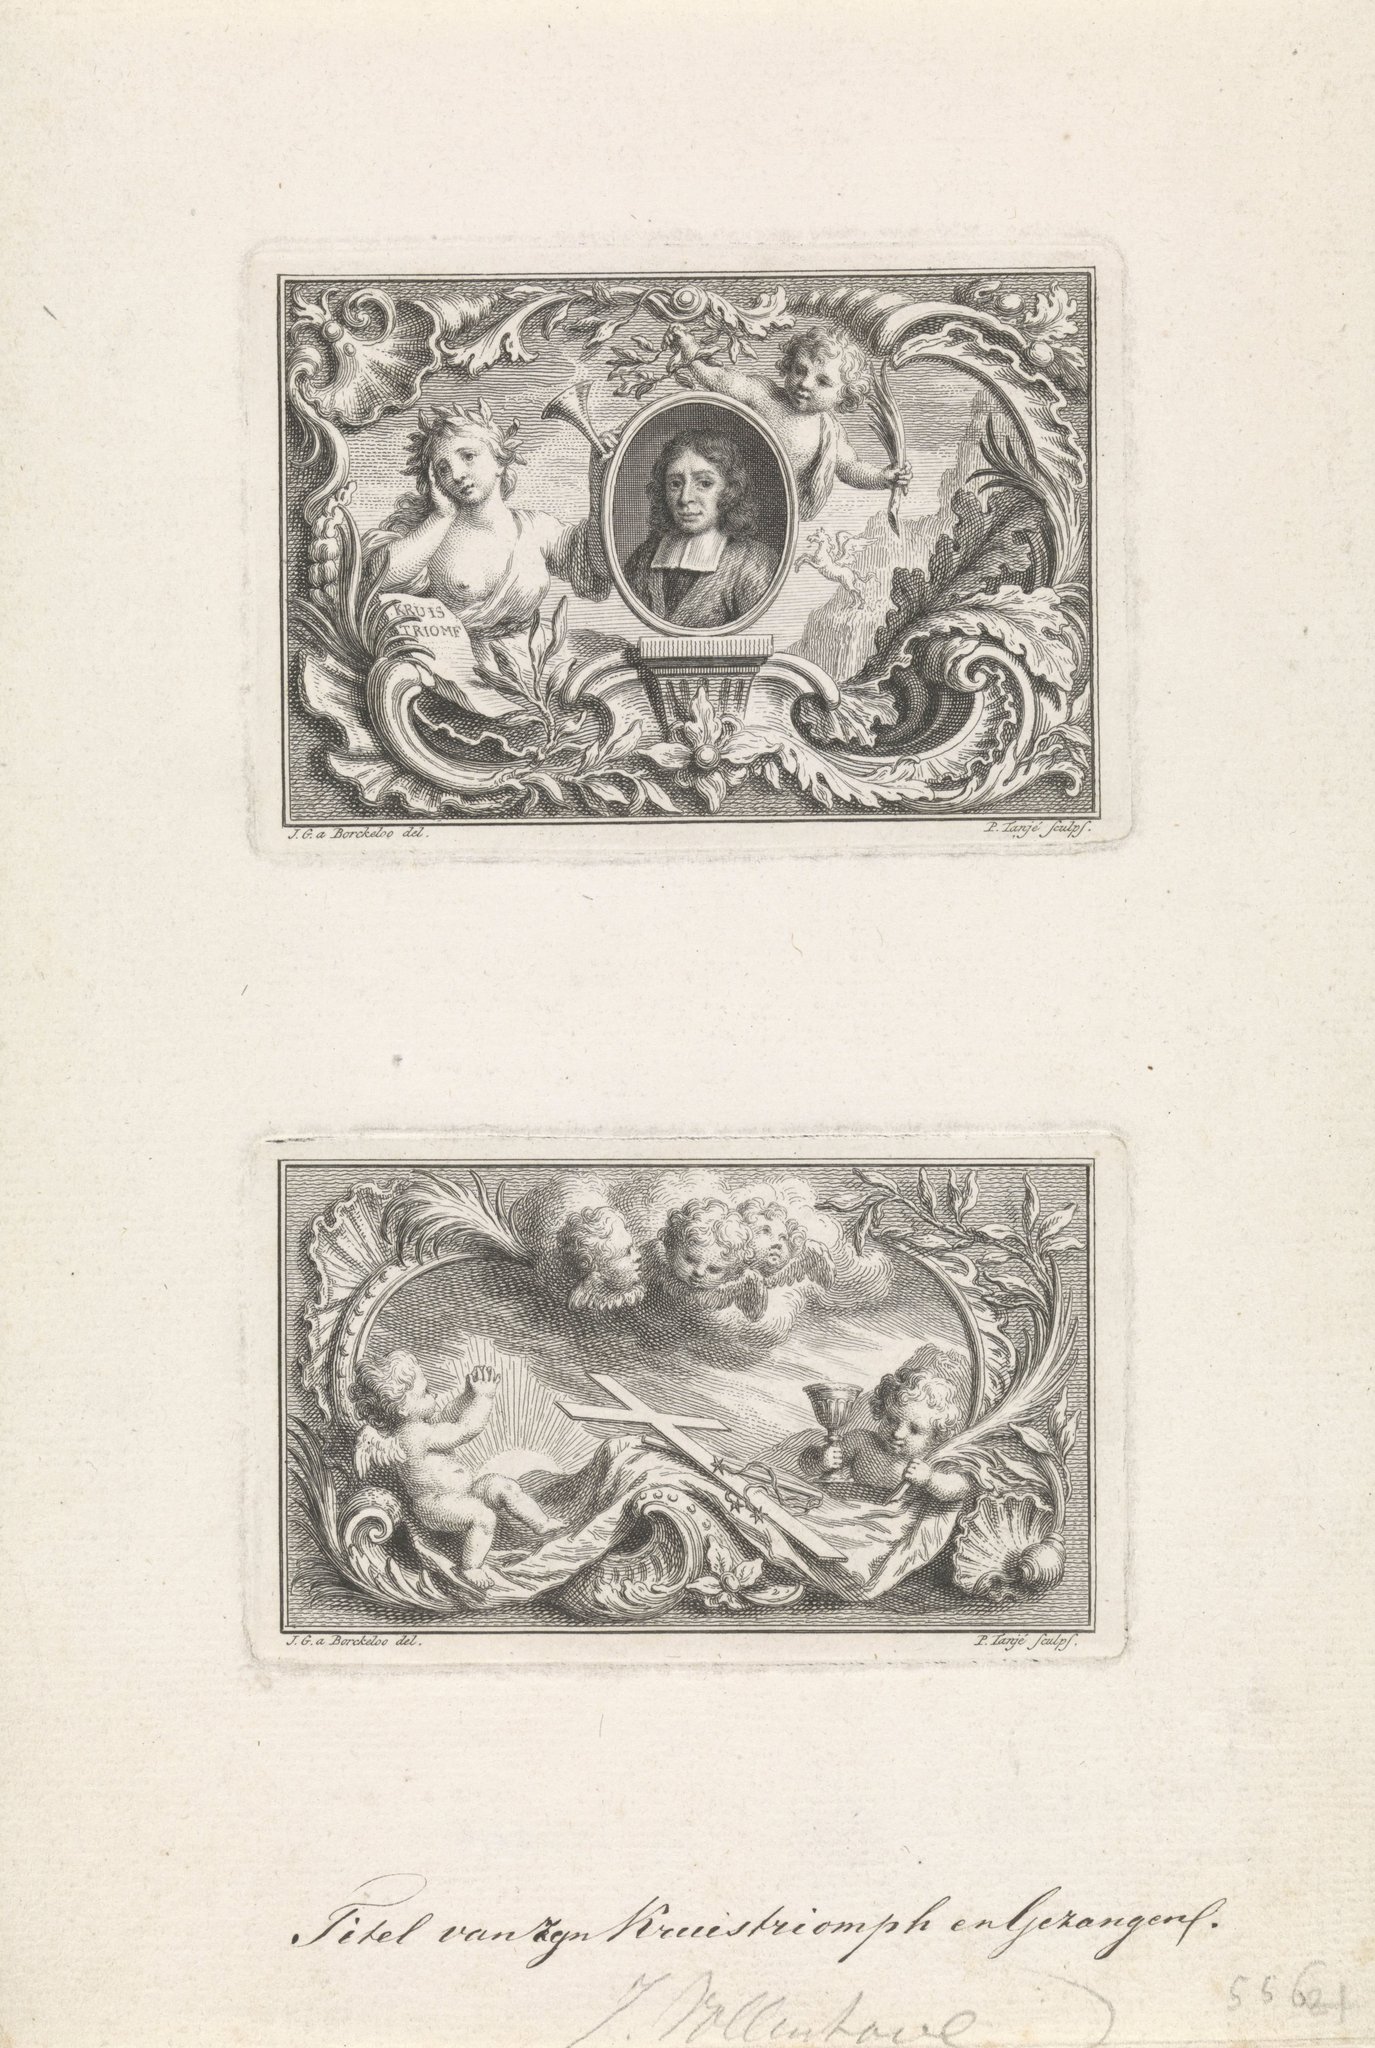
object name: book illustration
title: Titelpagina voor: J. Vollenhove, Kruistriomf en gezangen, 1750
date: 1750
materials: paper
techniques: engraving, etching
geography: amsterdam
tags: the hague, pegasus, the winged horse, the cross ~ symbols of christ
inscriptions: collector's mark: Lugt 2228, collector's mark: Lugt 2760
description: Twee voorstellingen op een blad. Boven: het portret van Joannes Vollenhove, predikant te Den Haag en schrijver van Kruistriomf en gezangen, wordt gekroond met een lauwerkrans door een putto. Op de achtergrond Pegasus bij de bron van poëtische inspiratie. Onder: een cartouche met twee putti bij het kruis van Christus. Een van hen houdt een miskelk en palmtak in de handen.